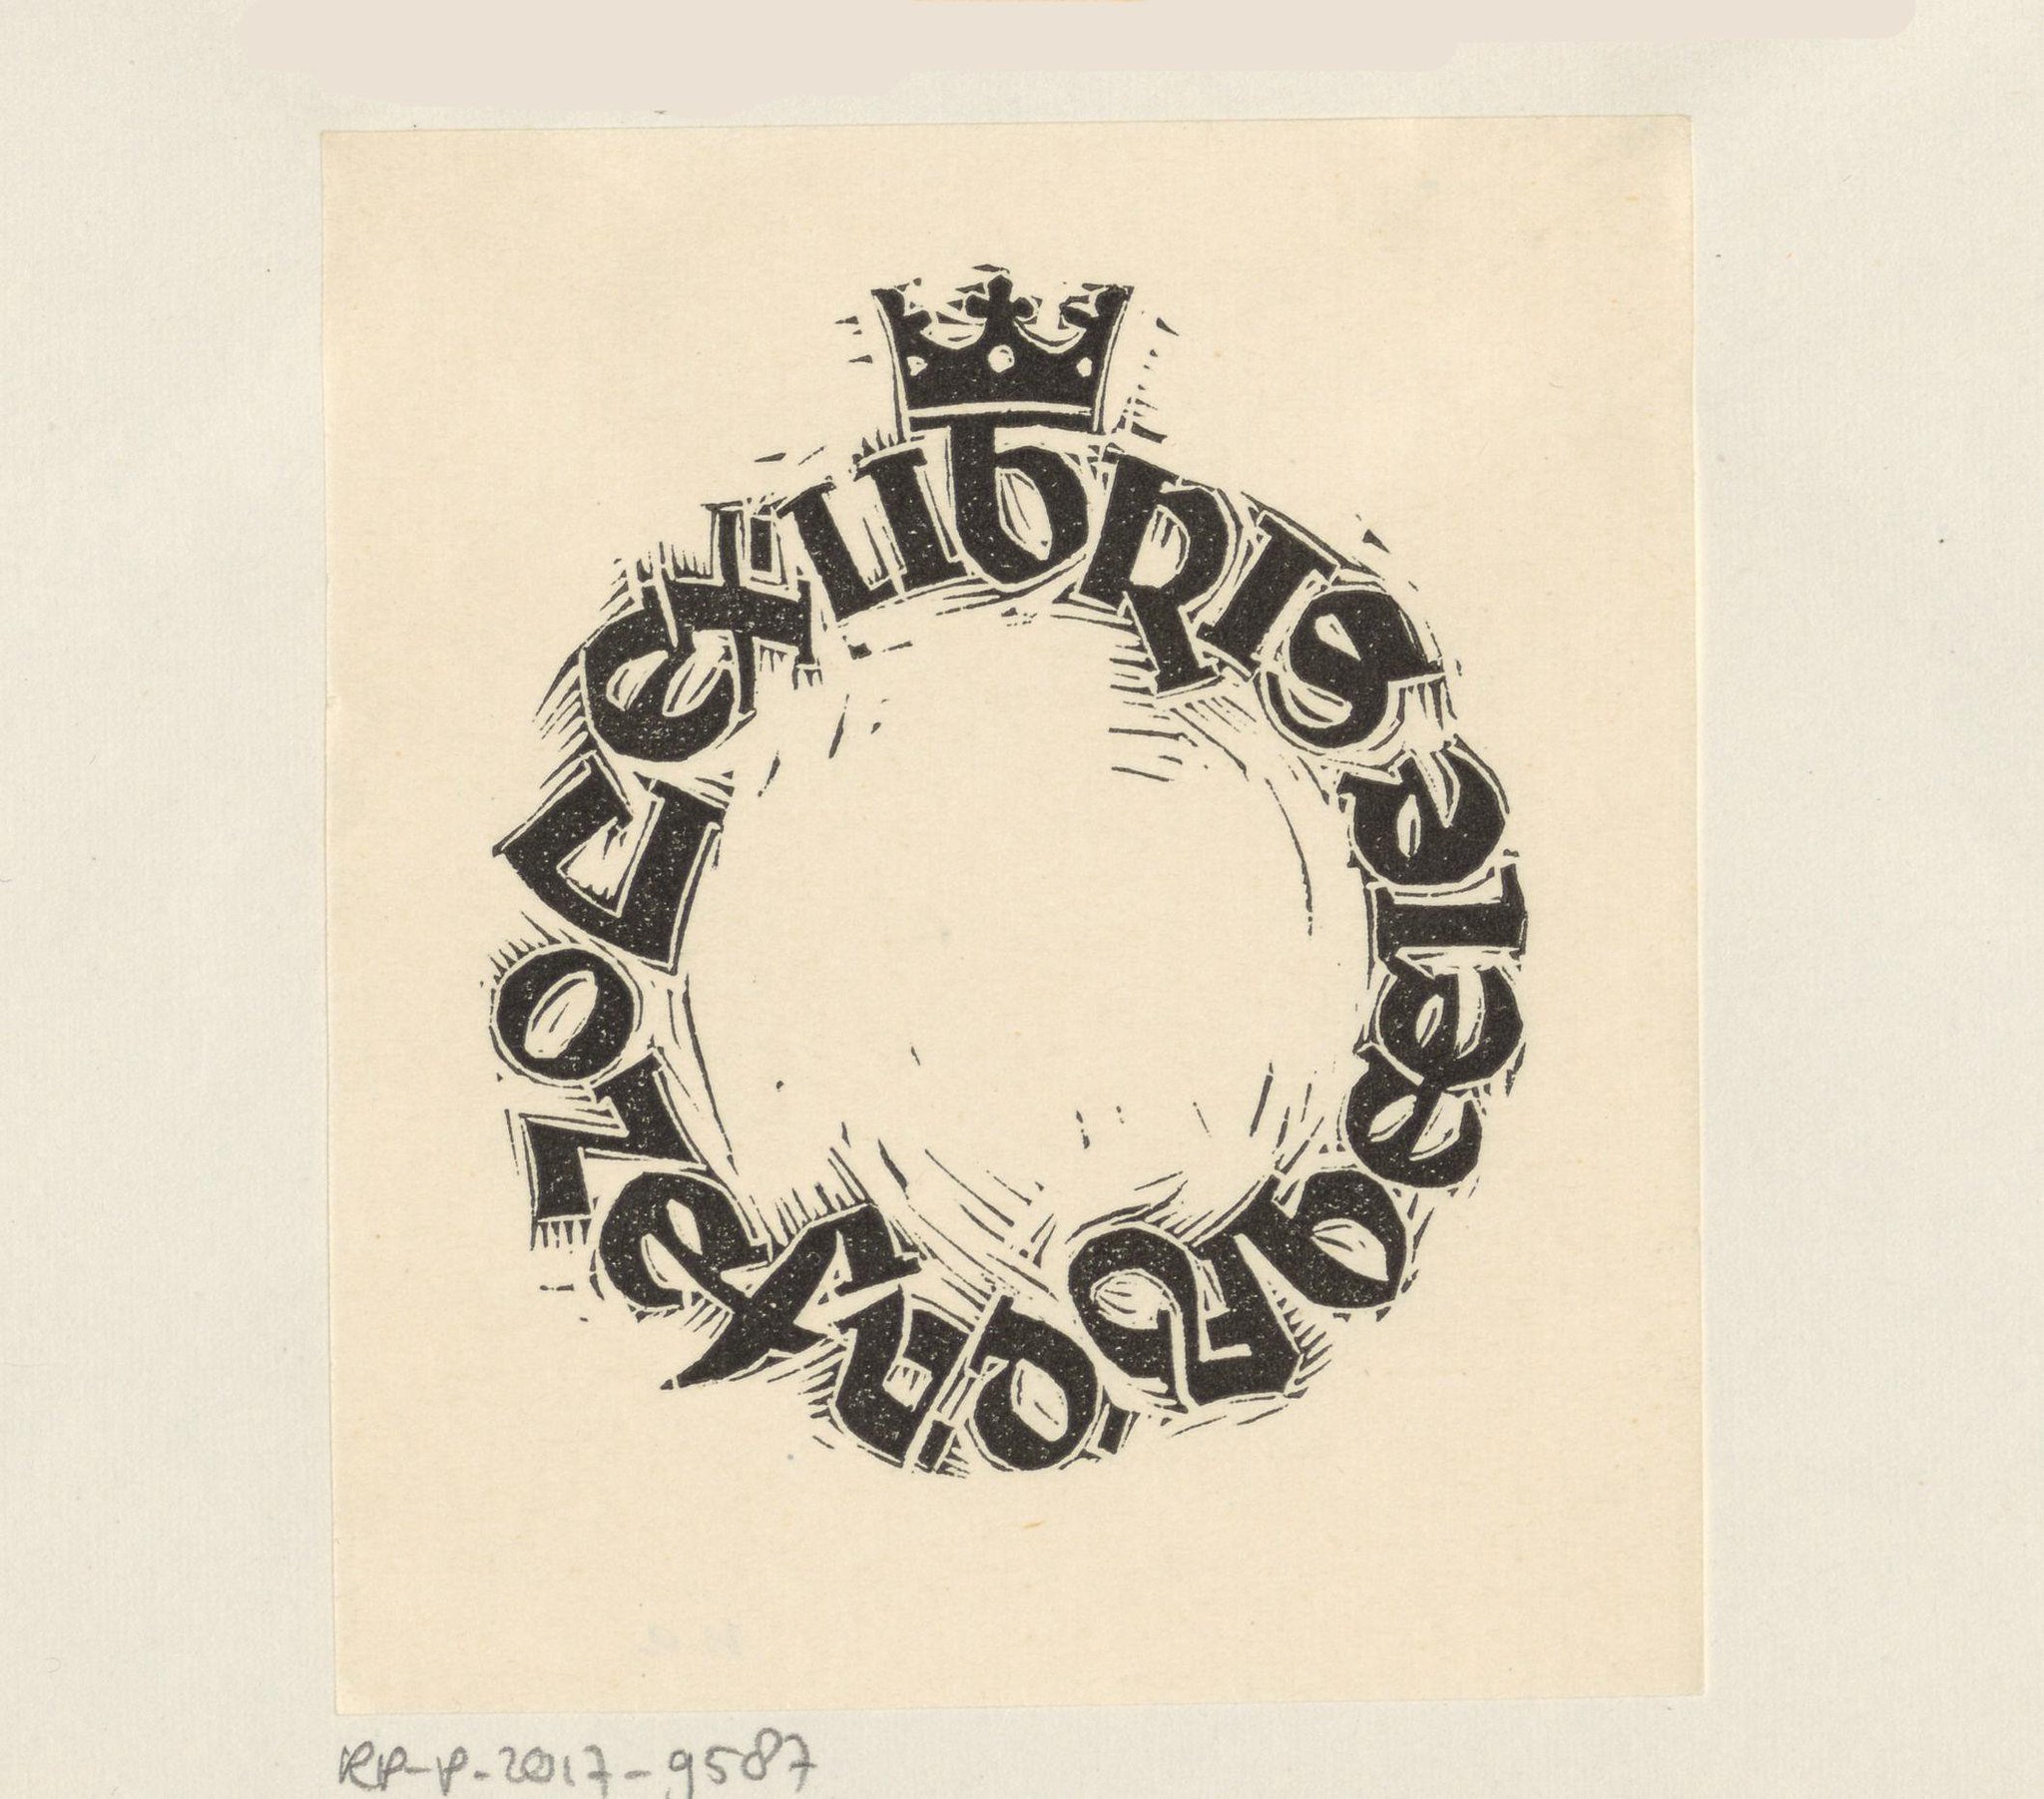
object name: bookplate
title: Ex libris Jozef v.d. Abeele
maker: jozef van den abeele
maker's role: print maker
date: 1900-1999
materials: paper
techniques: linocut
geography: belgium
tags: print maker, jozef van den abeele, crown (symbol of sovereignty)